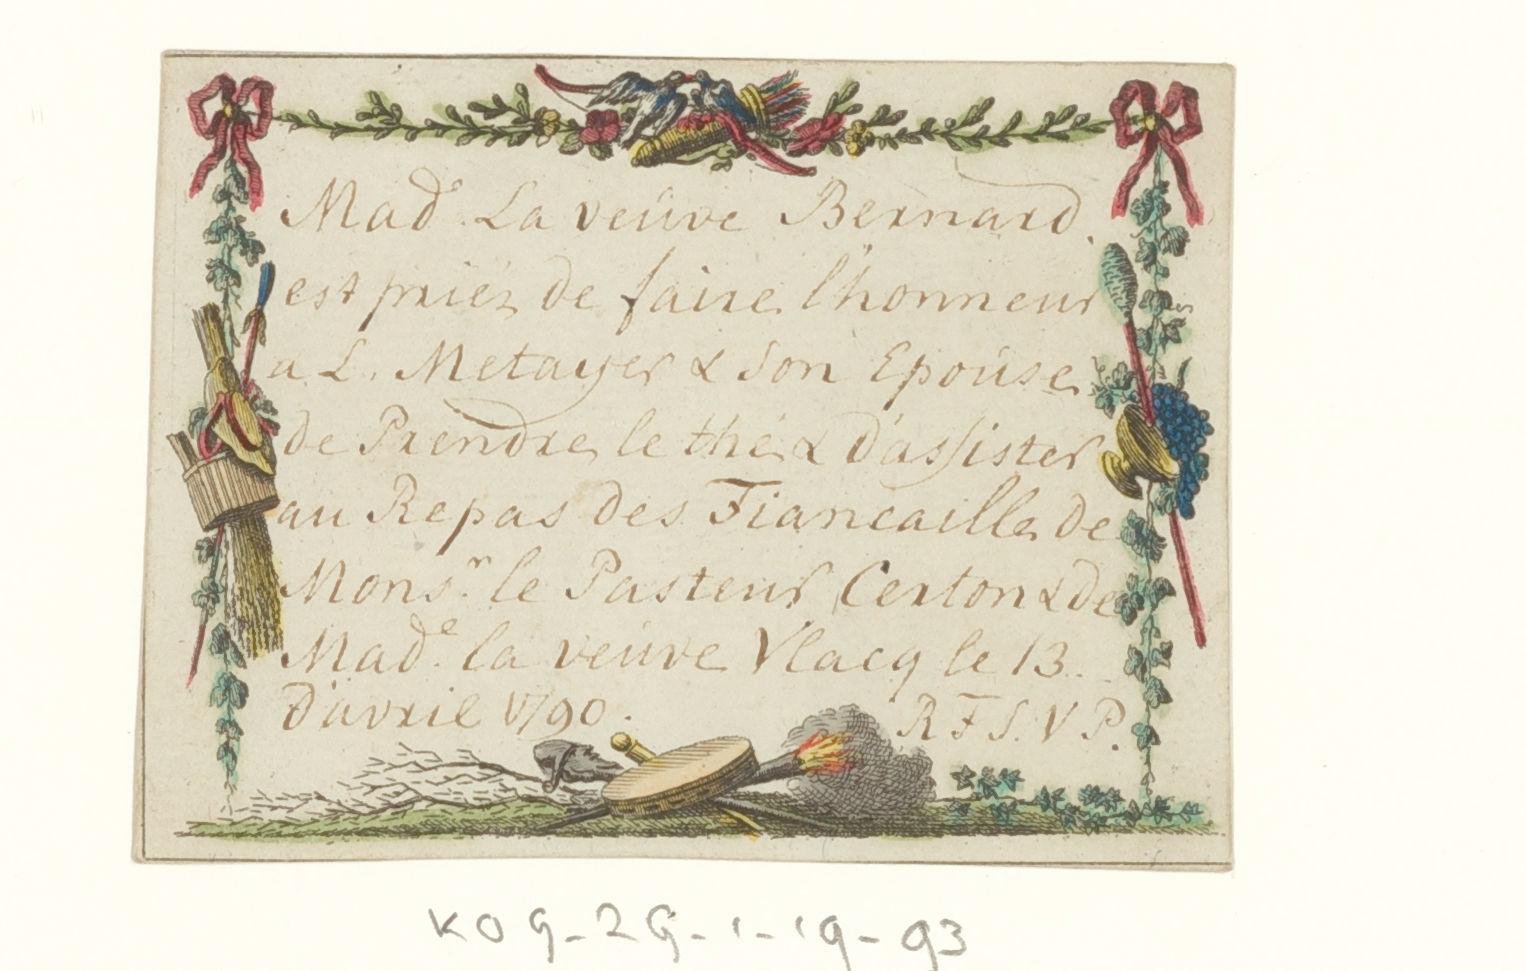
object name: print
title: Uitnodiging aan Mad.e veuve Bernard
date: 1704-1790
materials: paper, watercolor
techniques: etching, hand coloring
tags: goldsmith, louis metayer phzn., rotterdam, catharina elisabeth metayer, antoinette bernard, letter, envelope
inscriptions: collector's mark, collector's mark: Lugt 1641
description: Kaartje met een handgeschreven uitnodiging en RSVP aan mevr. de weduwe Bernard, namens L. Metayer en zijn vrouw voor het verlovingsdiner van de predikant Henri Abraham Certon en Mad.e la Veuve Vlacq (Catharina Elisabeth Metayer) op 13 april 1790. Onderdeel van een groep van bruilofts- en invitatiekaartjes van de families Bernard en Metayer. Onderwerpsrubrieken binnen de Atlas Zeden en Gewoonten: Des Menschen Begin, Midden en Einde. Bruiloft en huwelijk.